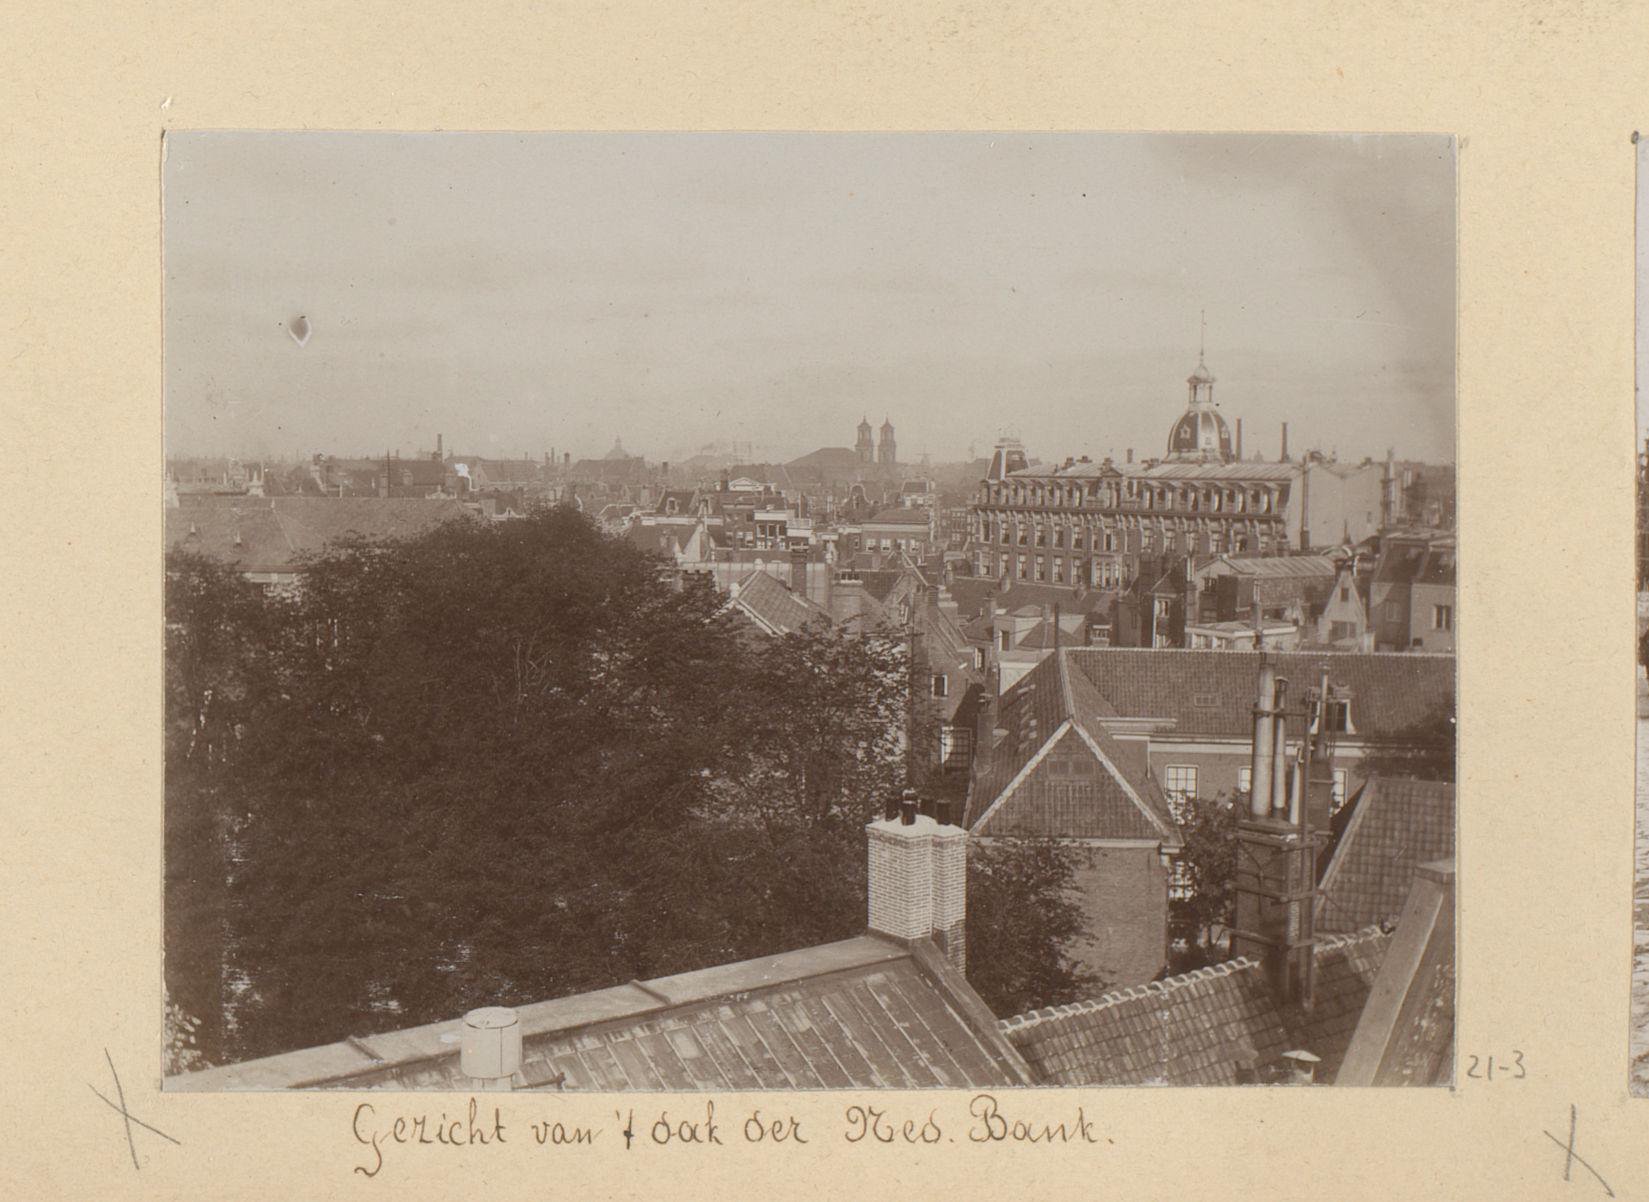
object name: photograph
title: Gezicht van 't dak der Ned. Bank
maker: hendrik herman van den berg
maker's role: amateurfotograaf, jurist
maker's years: 1875-1944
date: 1890-1894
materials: paper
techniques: collodion silver print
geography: amsterdam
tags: city-view in general; 'veduta'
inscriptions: annotation: ‘Gezicht van 't dak der Ned. Bank’, annotation: ‘Amsterdam +/- 1890’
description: Foto 3 op albumblad 21 uit album "Amsterdam 1890-1894".